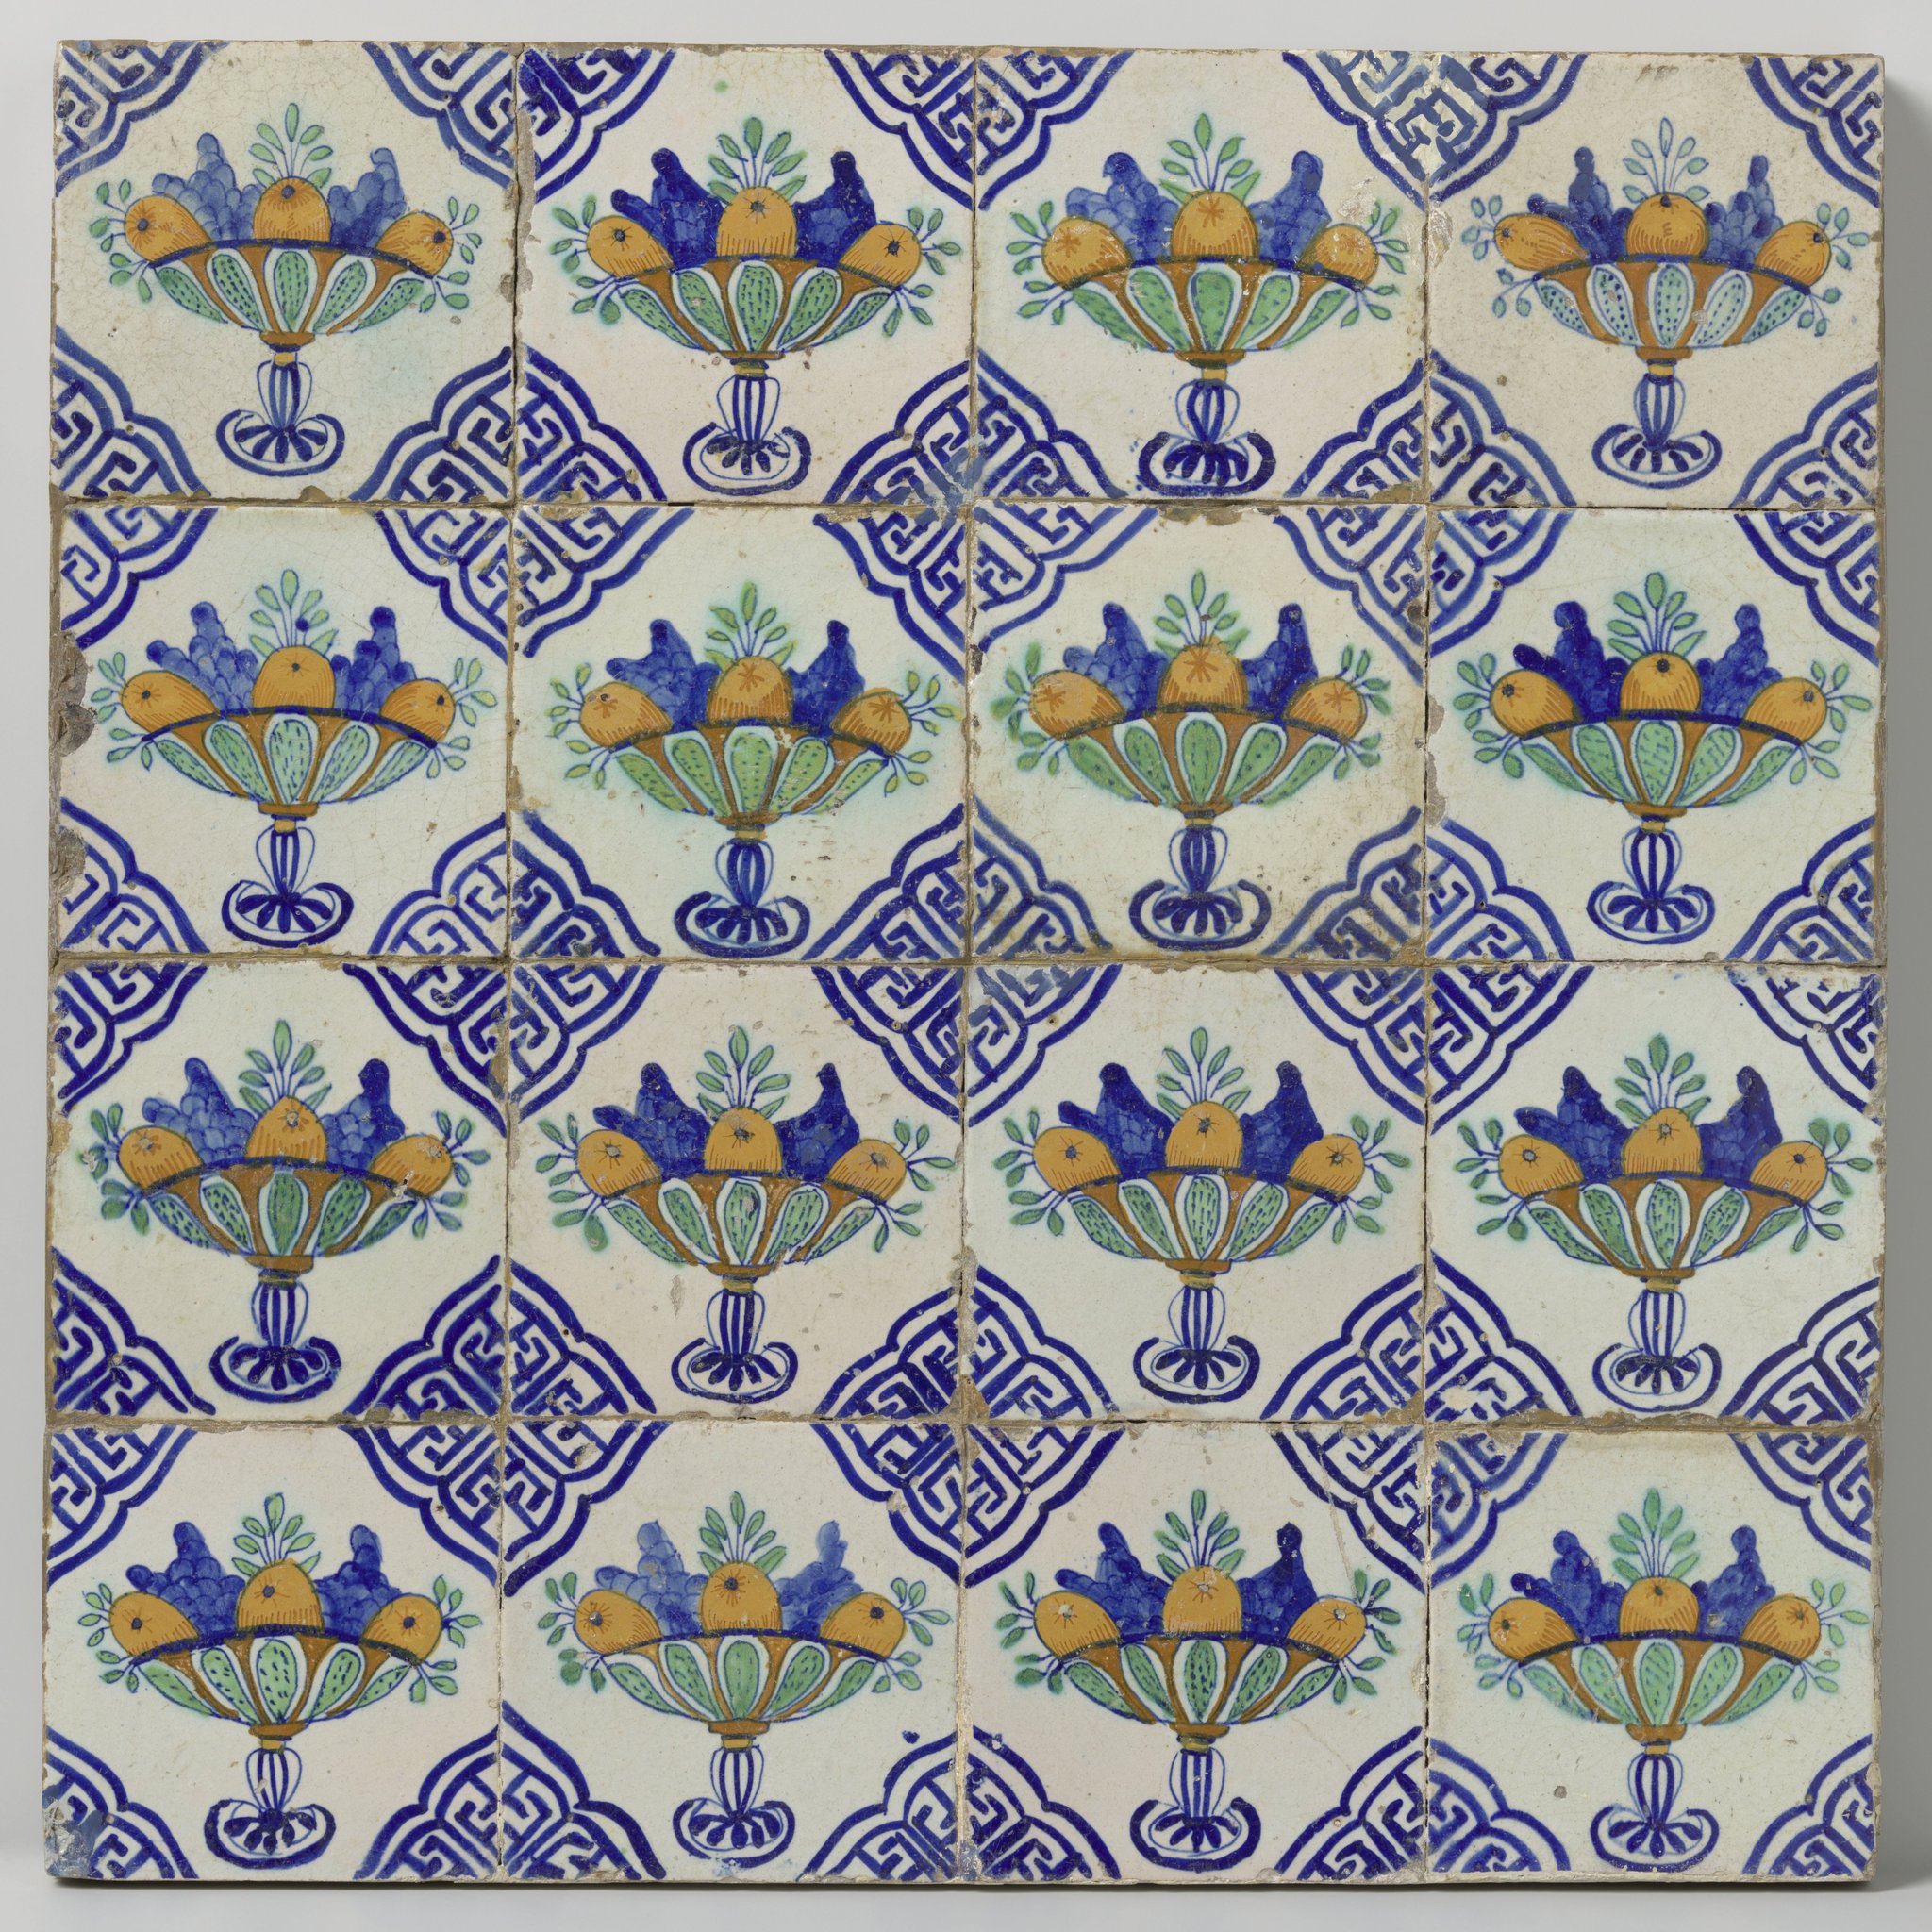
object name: tile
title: Veld van zestien tegels met fruitschalen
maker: Anonymous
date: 1625-1650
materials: earthenware, glaze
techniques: maiolica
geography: netherlands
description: Veld van zestien tegels (4 x 4) elk met een veelkleurige (blauw, oranje en groen) fruitschaal op voet met granaatappels en druiventrossen. In de hoeken, een meander. Op de achterzijde, gemerkt in zwart: V/17 WUO.